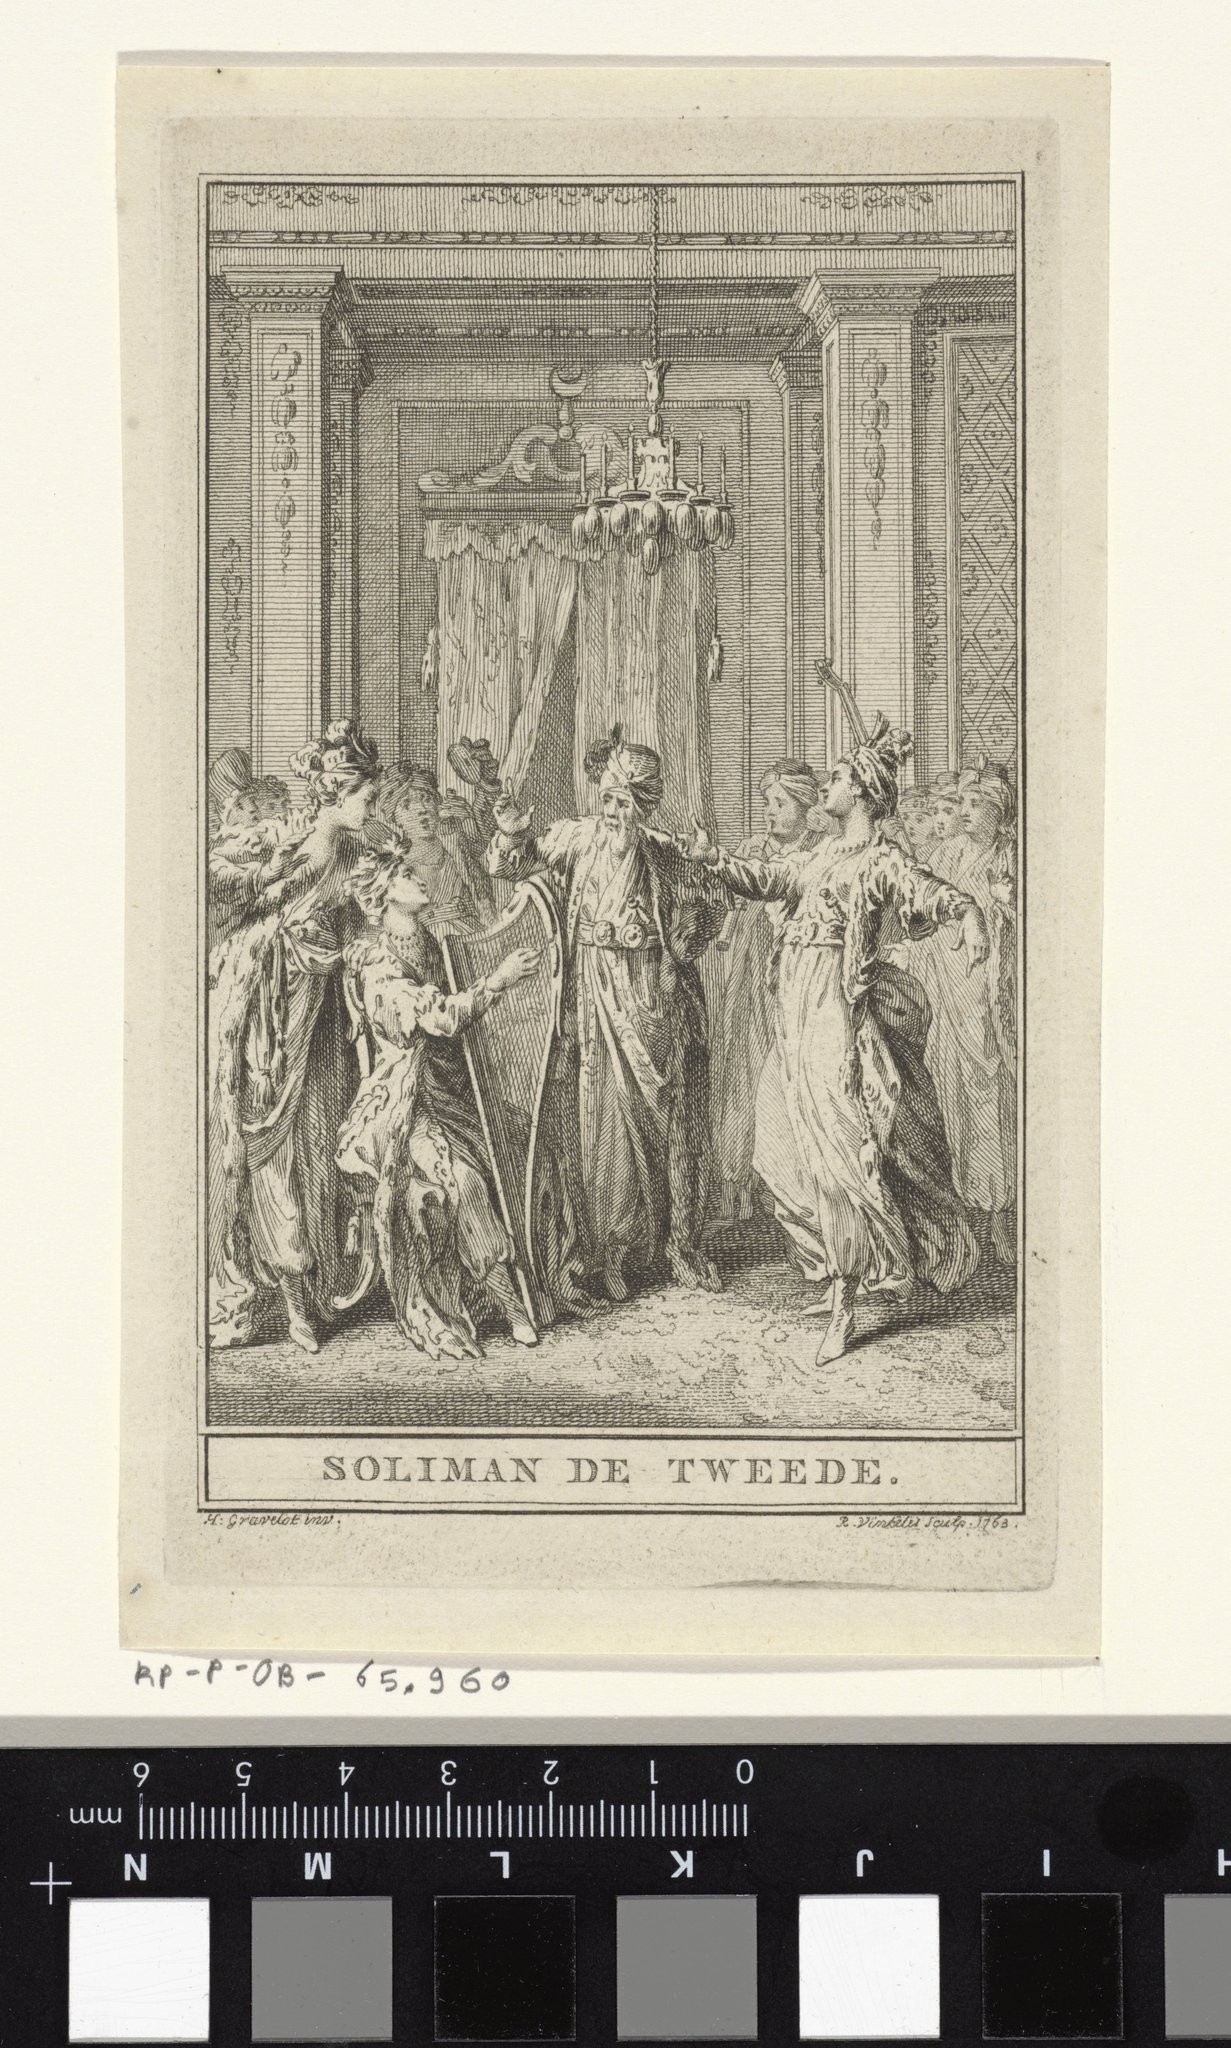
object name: print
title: Sultan omringd door dansende en musicerende figuren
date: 1763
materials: paper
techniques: engraving, etching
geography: amsterdam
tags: making music; musician with instrument, dancing, head-gear: turban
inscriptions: collector's mark: Lugt 2228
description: Mogelijk illustratie uit: Nomsz, J. Soliman de tweede, of De drie sultanes; blyspel. Amsterdam: Izaak Duim, 1775.